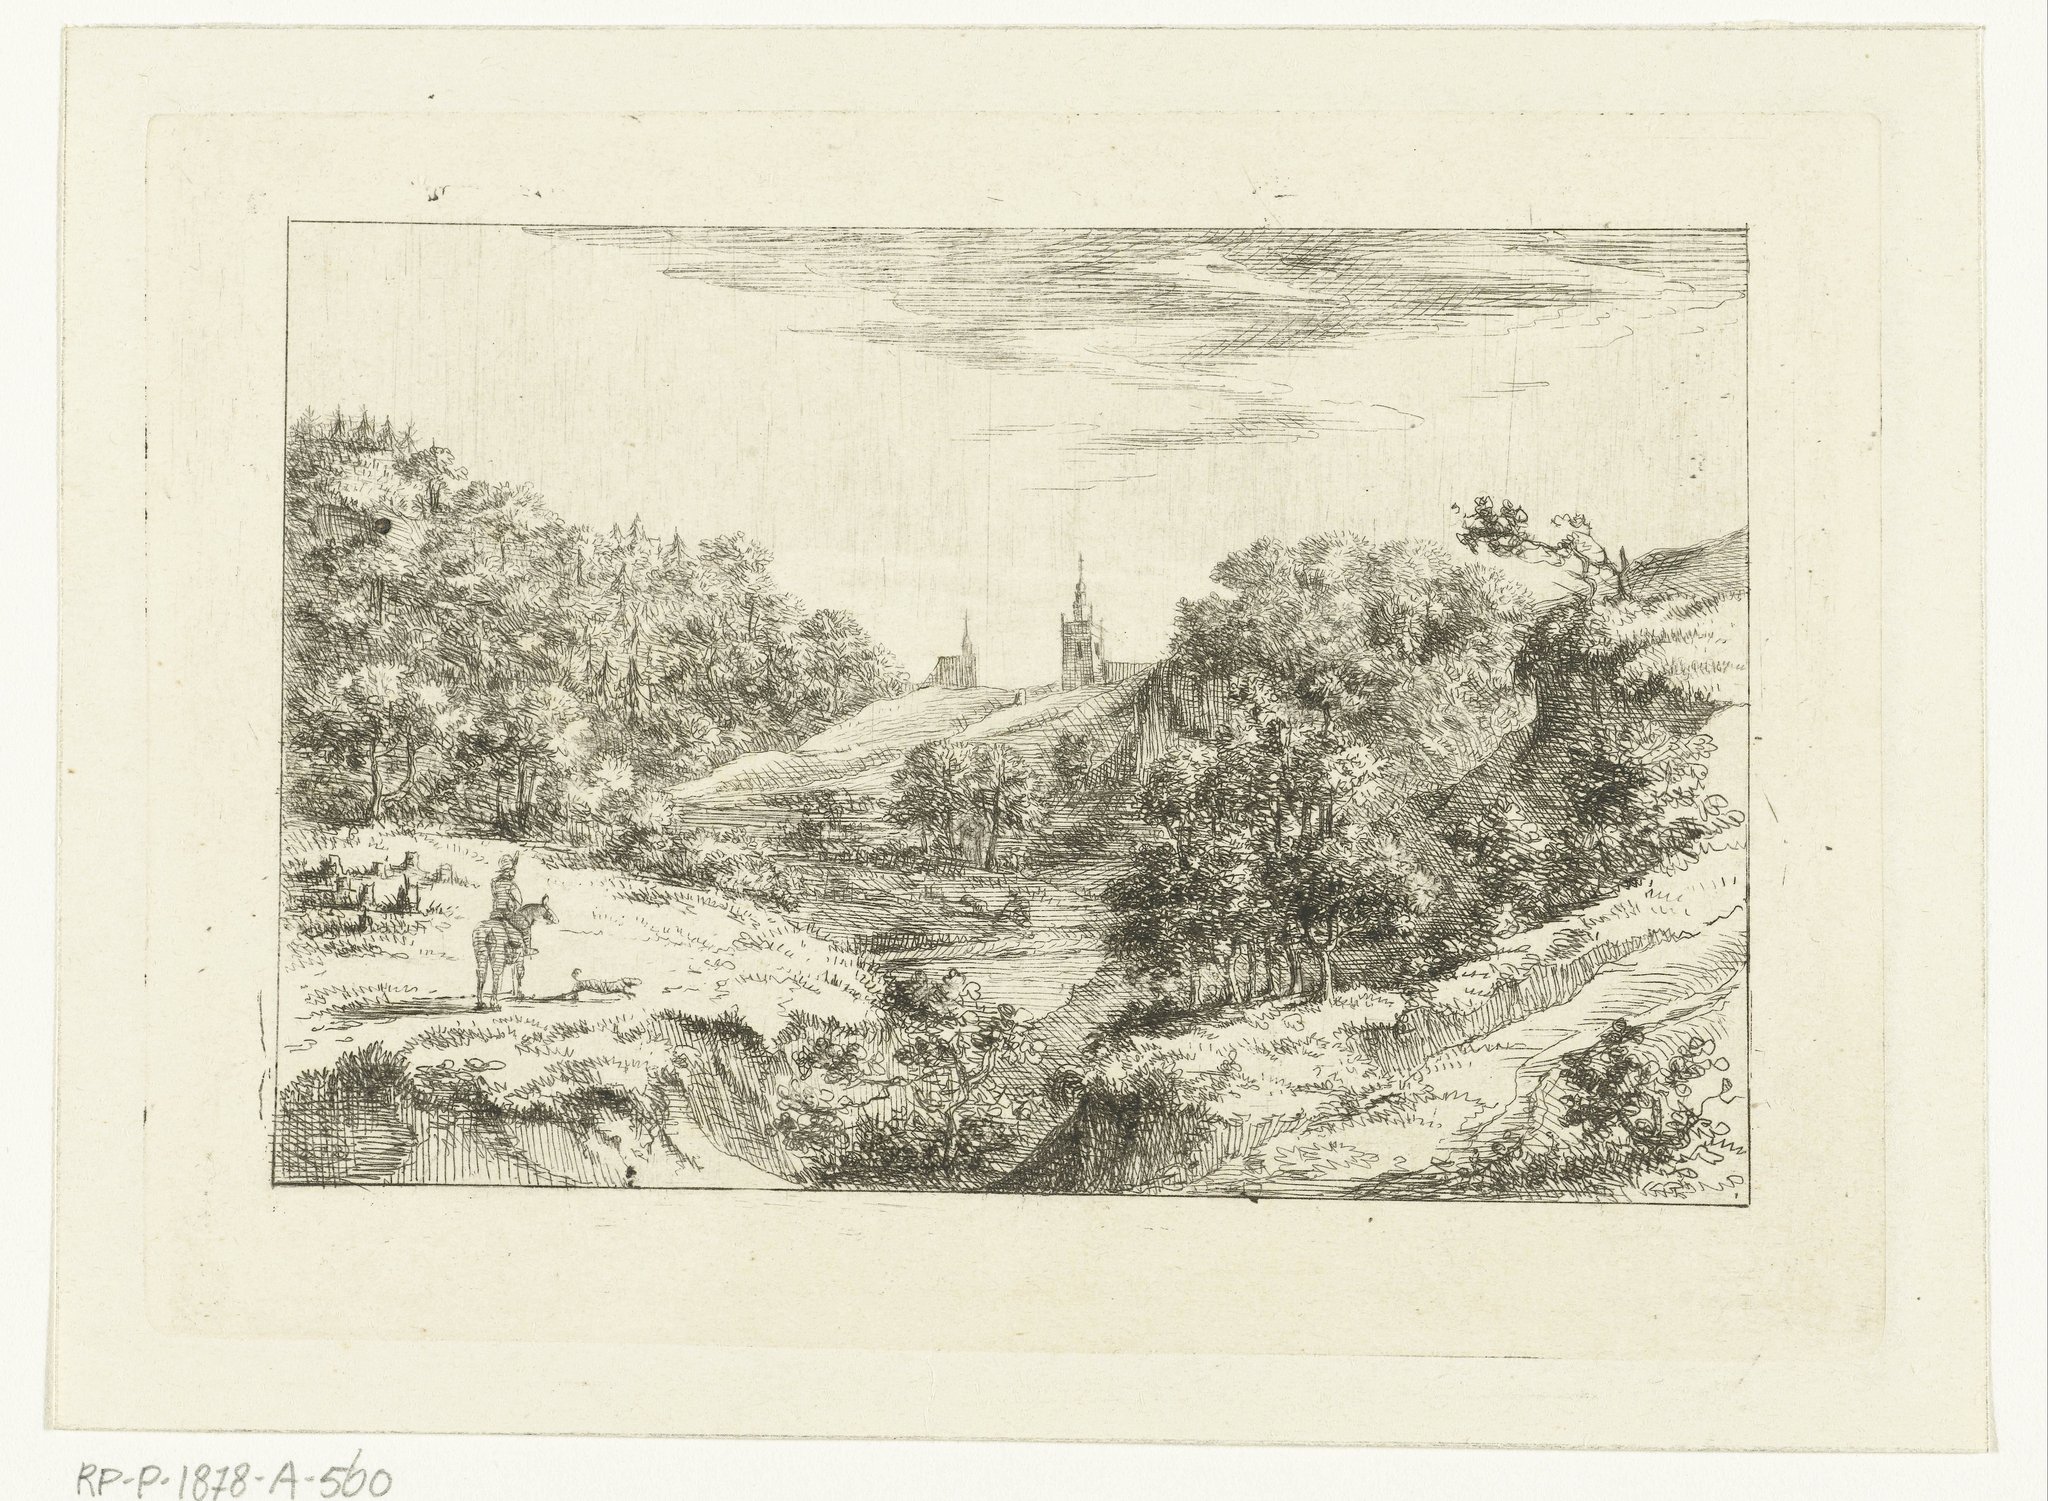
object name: print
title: Duinlandschap met kerken en ruiter bij Scheveningen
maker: dirk vis blokhuyzen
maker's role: print maker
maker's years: 1799-1869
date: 1809-1869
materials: paper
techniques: etching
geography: rotterdam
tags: dunes (sea not visible); in the dunes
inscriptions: collector's mark: Lugt 2228